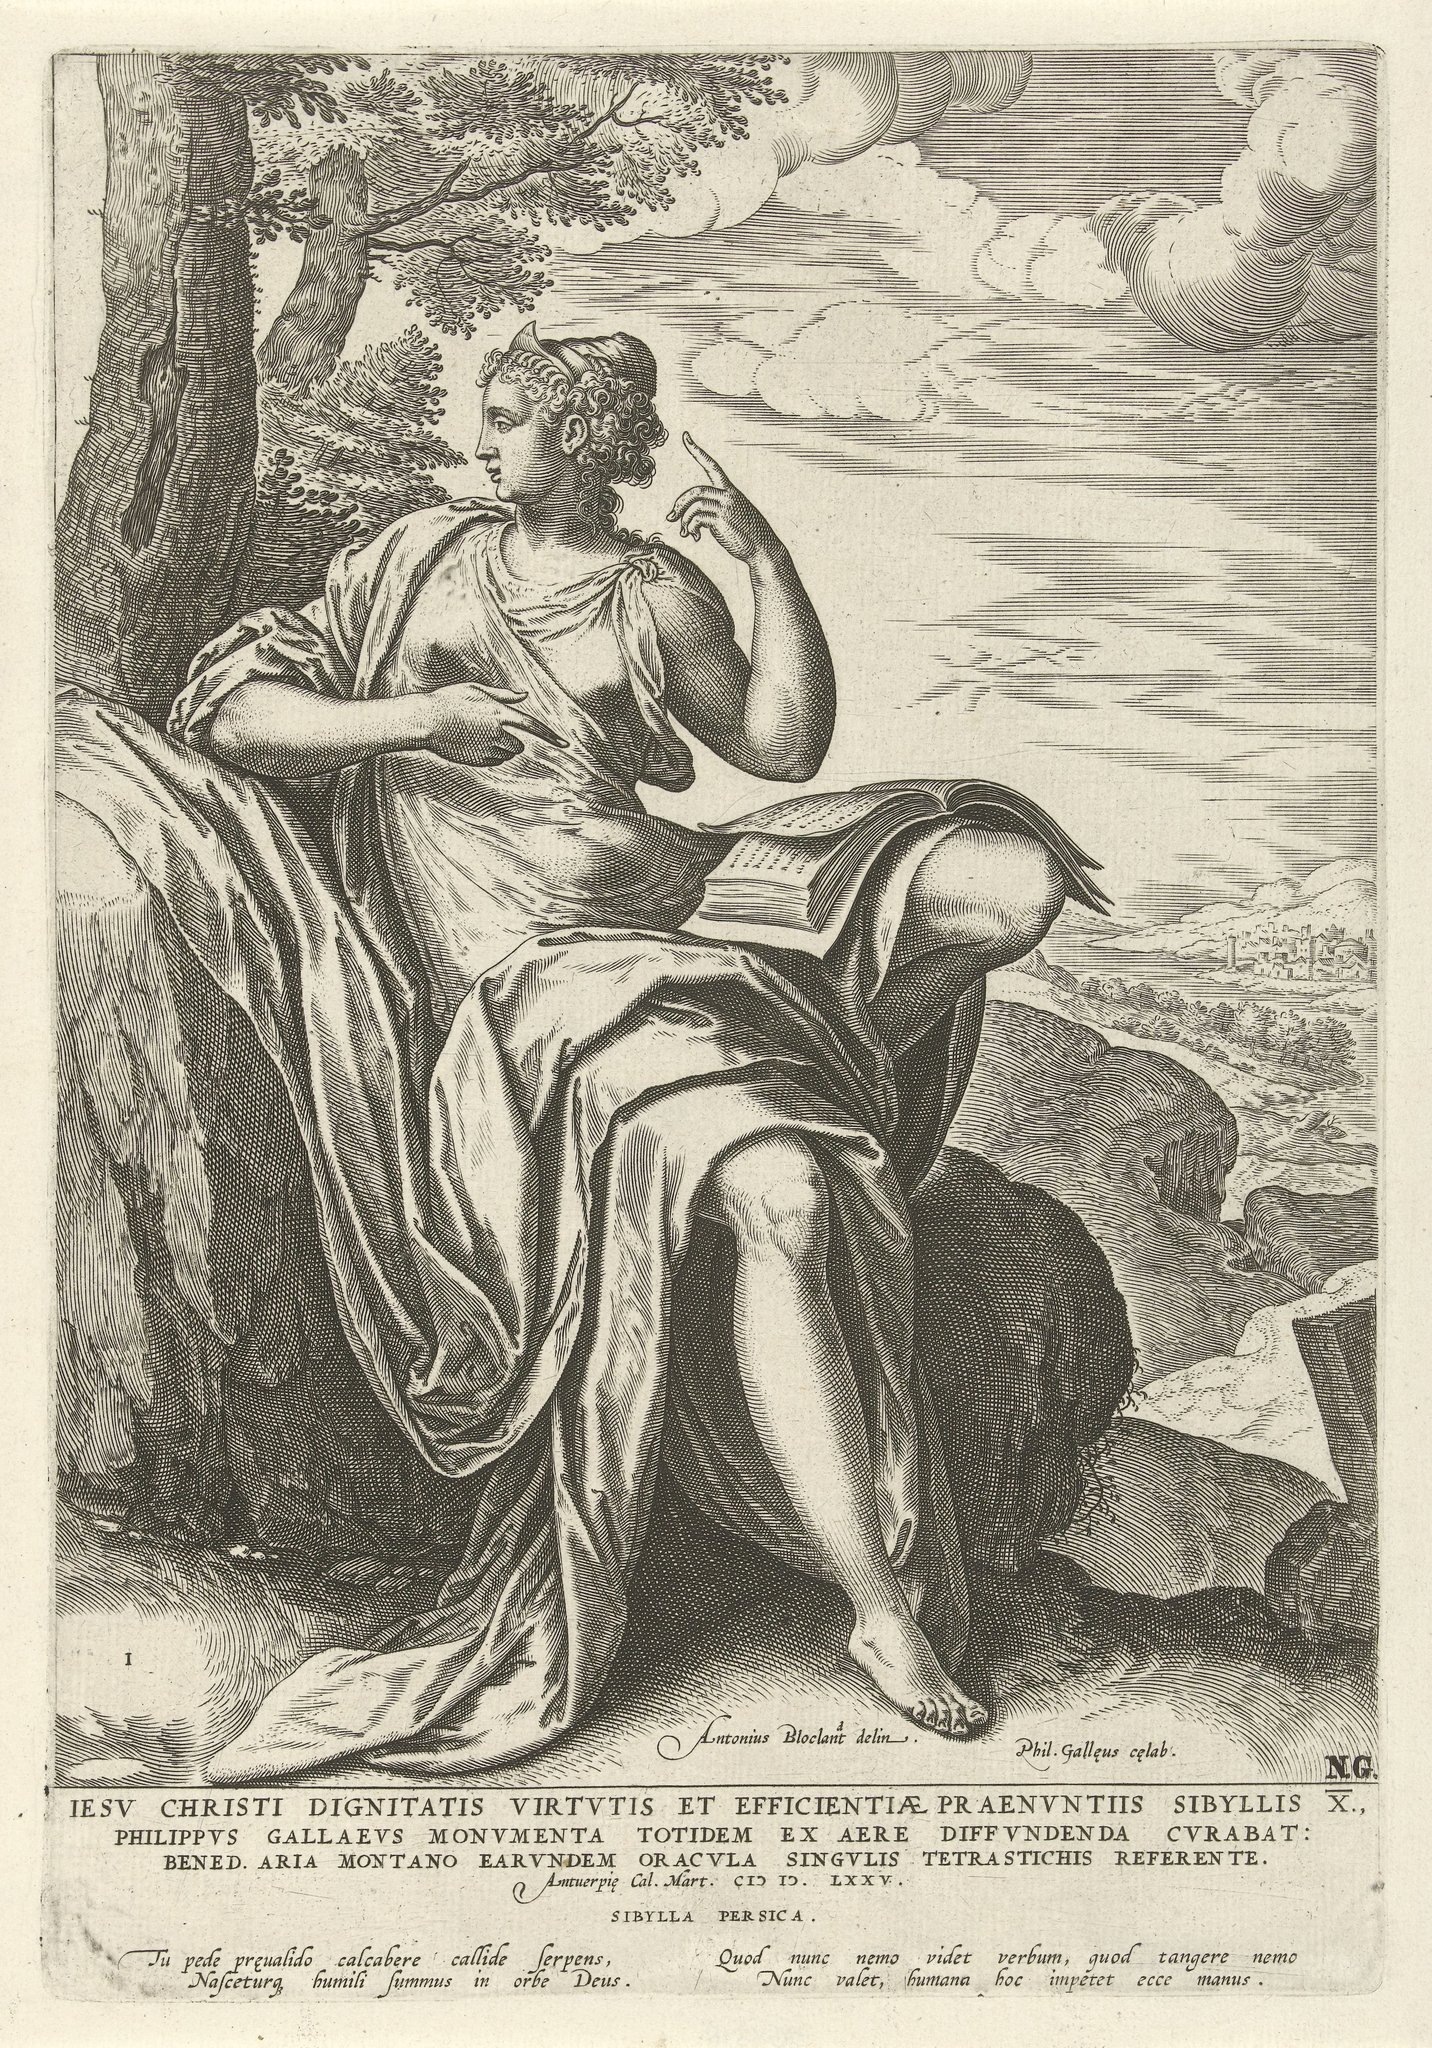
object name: titelprent, frontispice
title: Sibylla Persica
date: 1575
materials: paper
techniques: engraving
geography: antwerp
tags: persian sibyl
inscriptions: collector's mark: Lugt 2228, collector's mark: Lugt 1967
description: De Perzische Sibille zit op een rots. Op haar schoot een open boek. De prent heeft een Latijns onderschrift en is de titelprent van een tiendelige serie over de Sibillen.